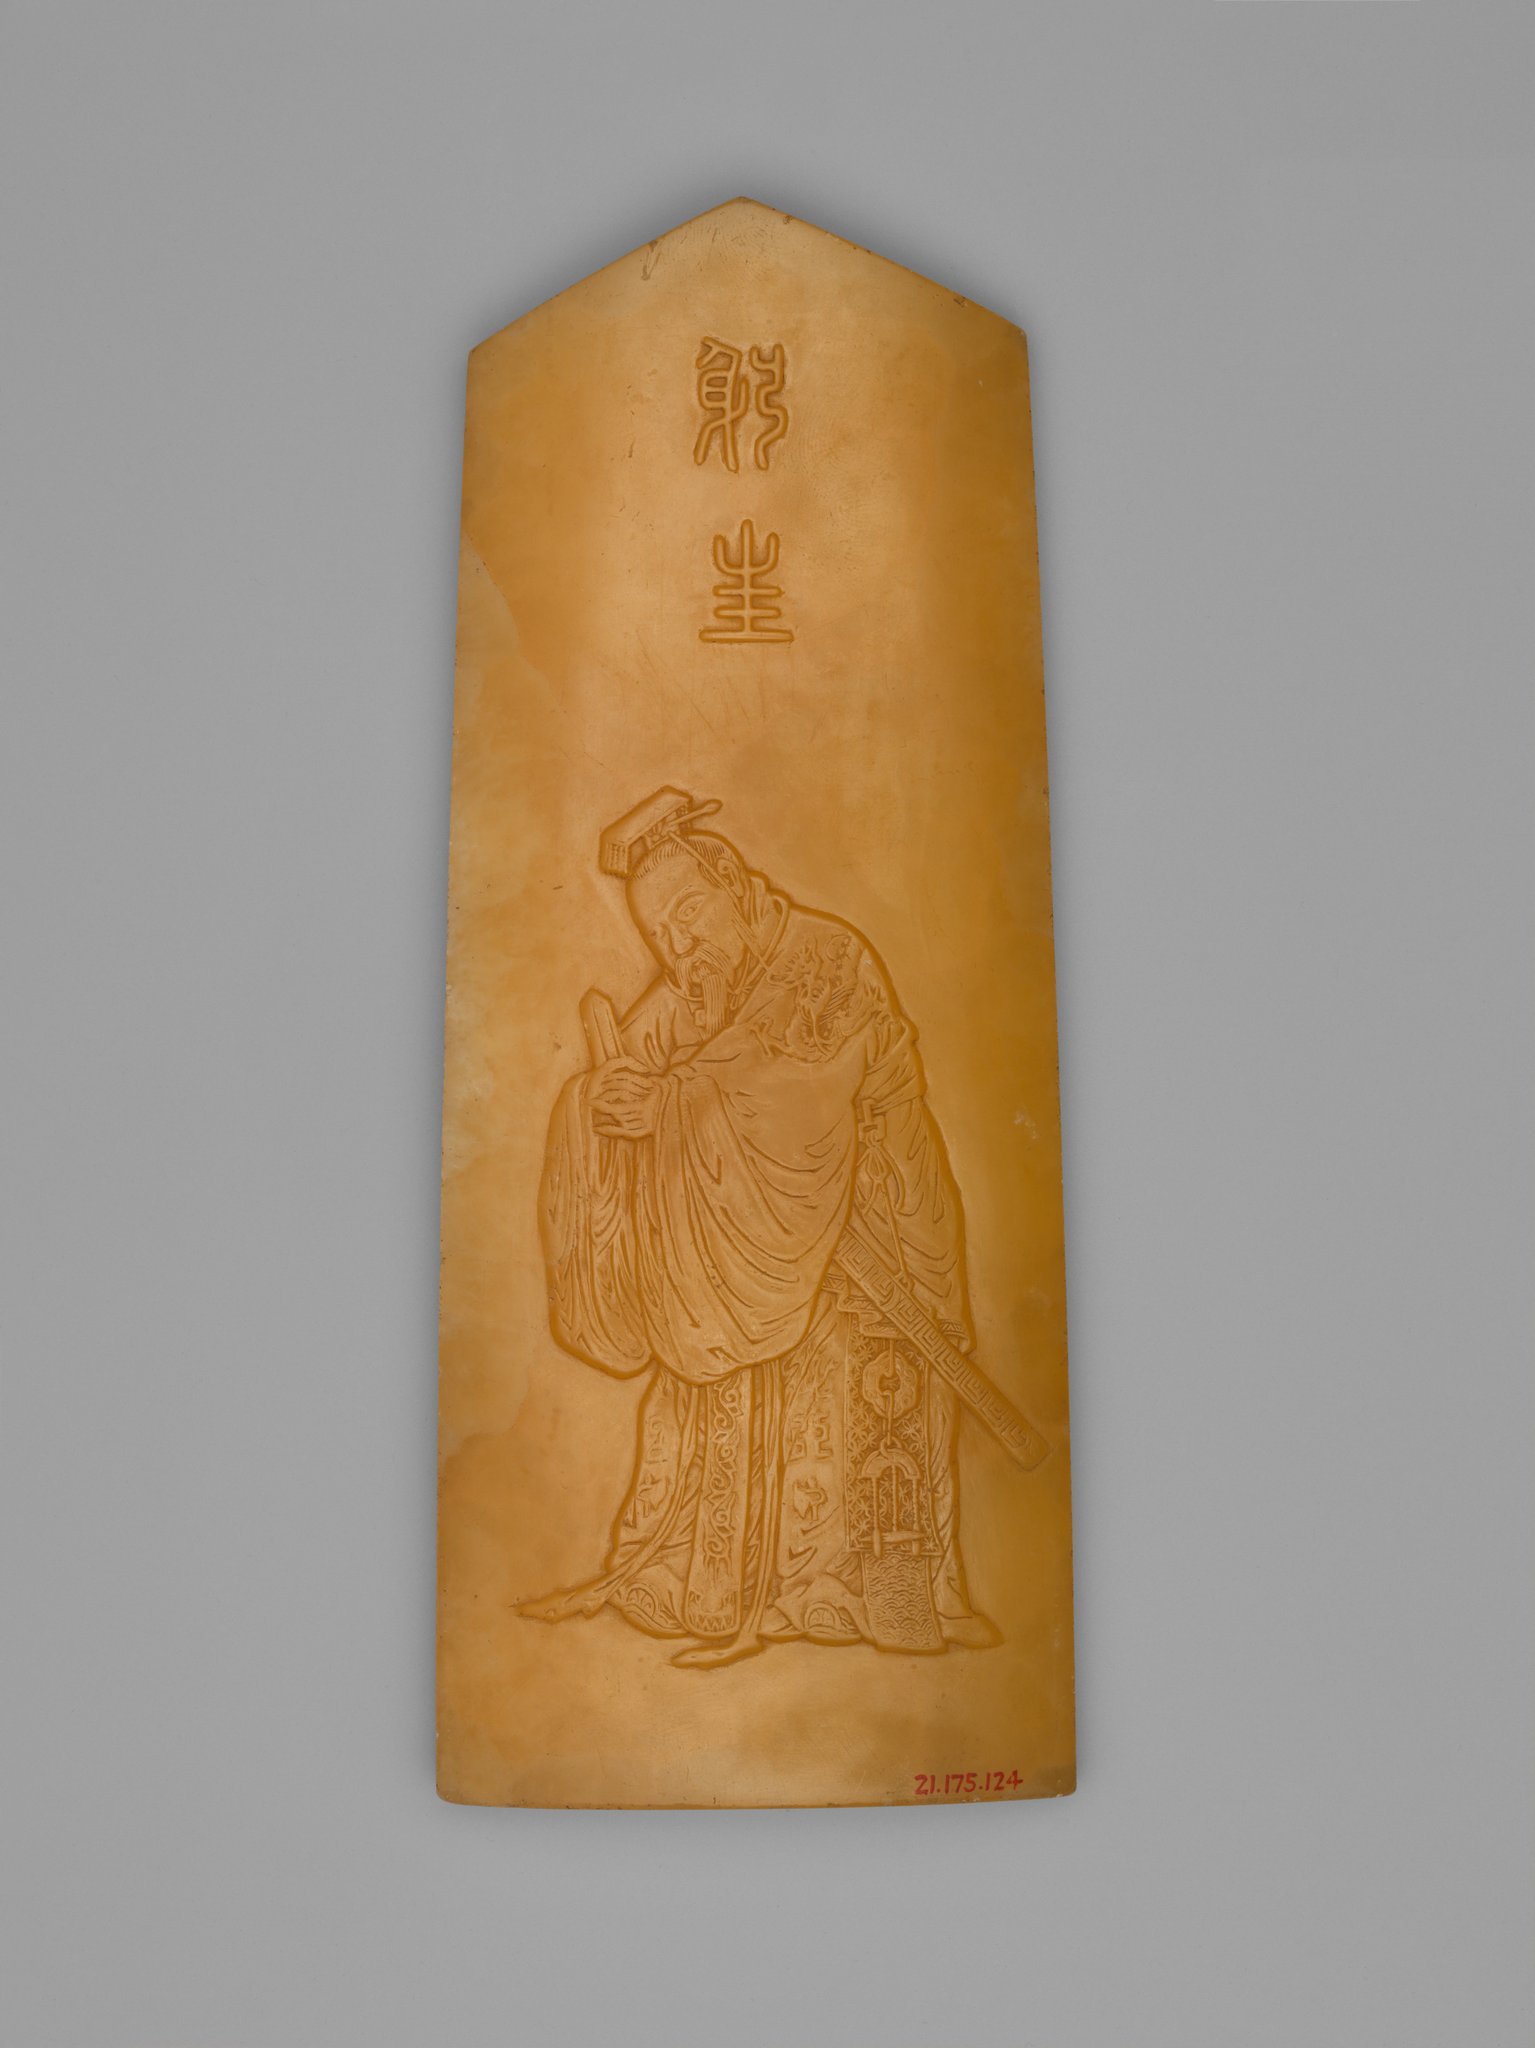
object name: tablet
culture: chinese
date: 1736-1795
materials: alabaster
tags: men